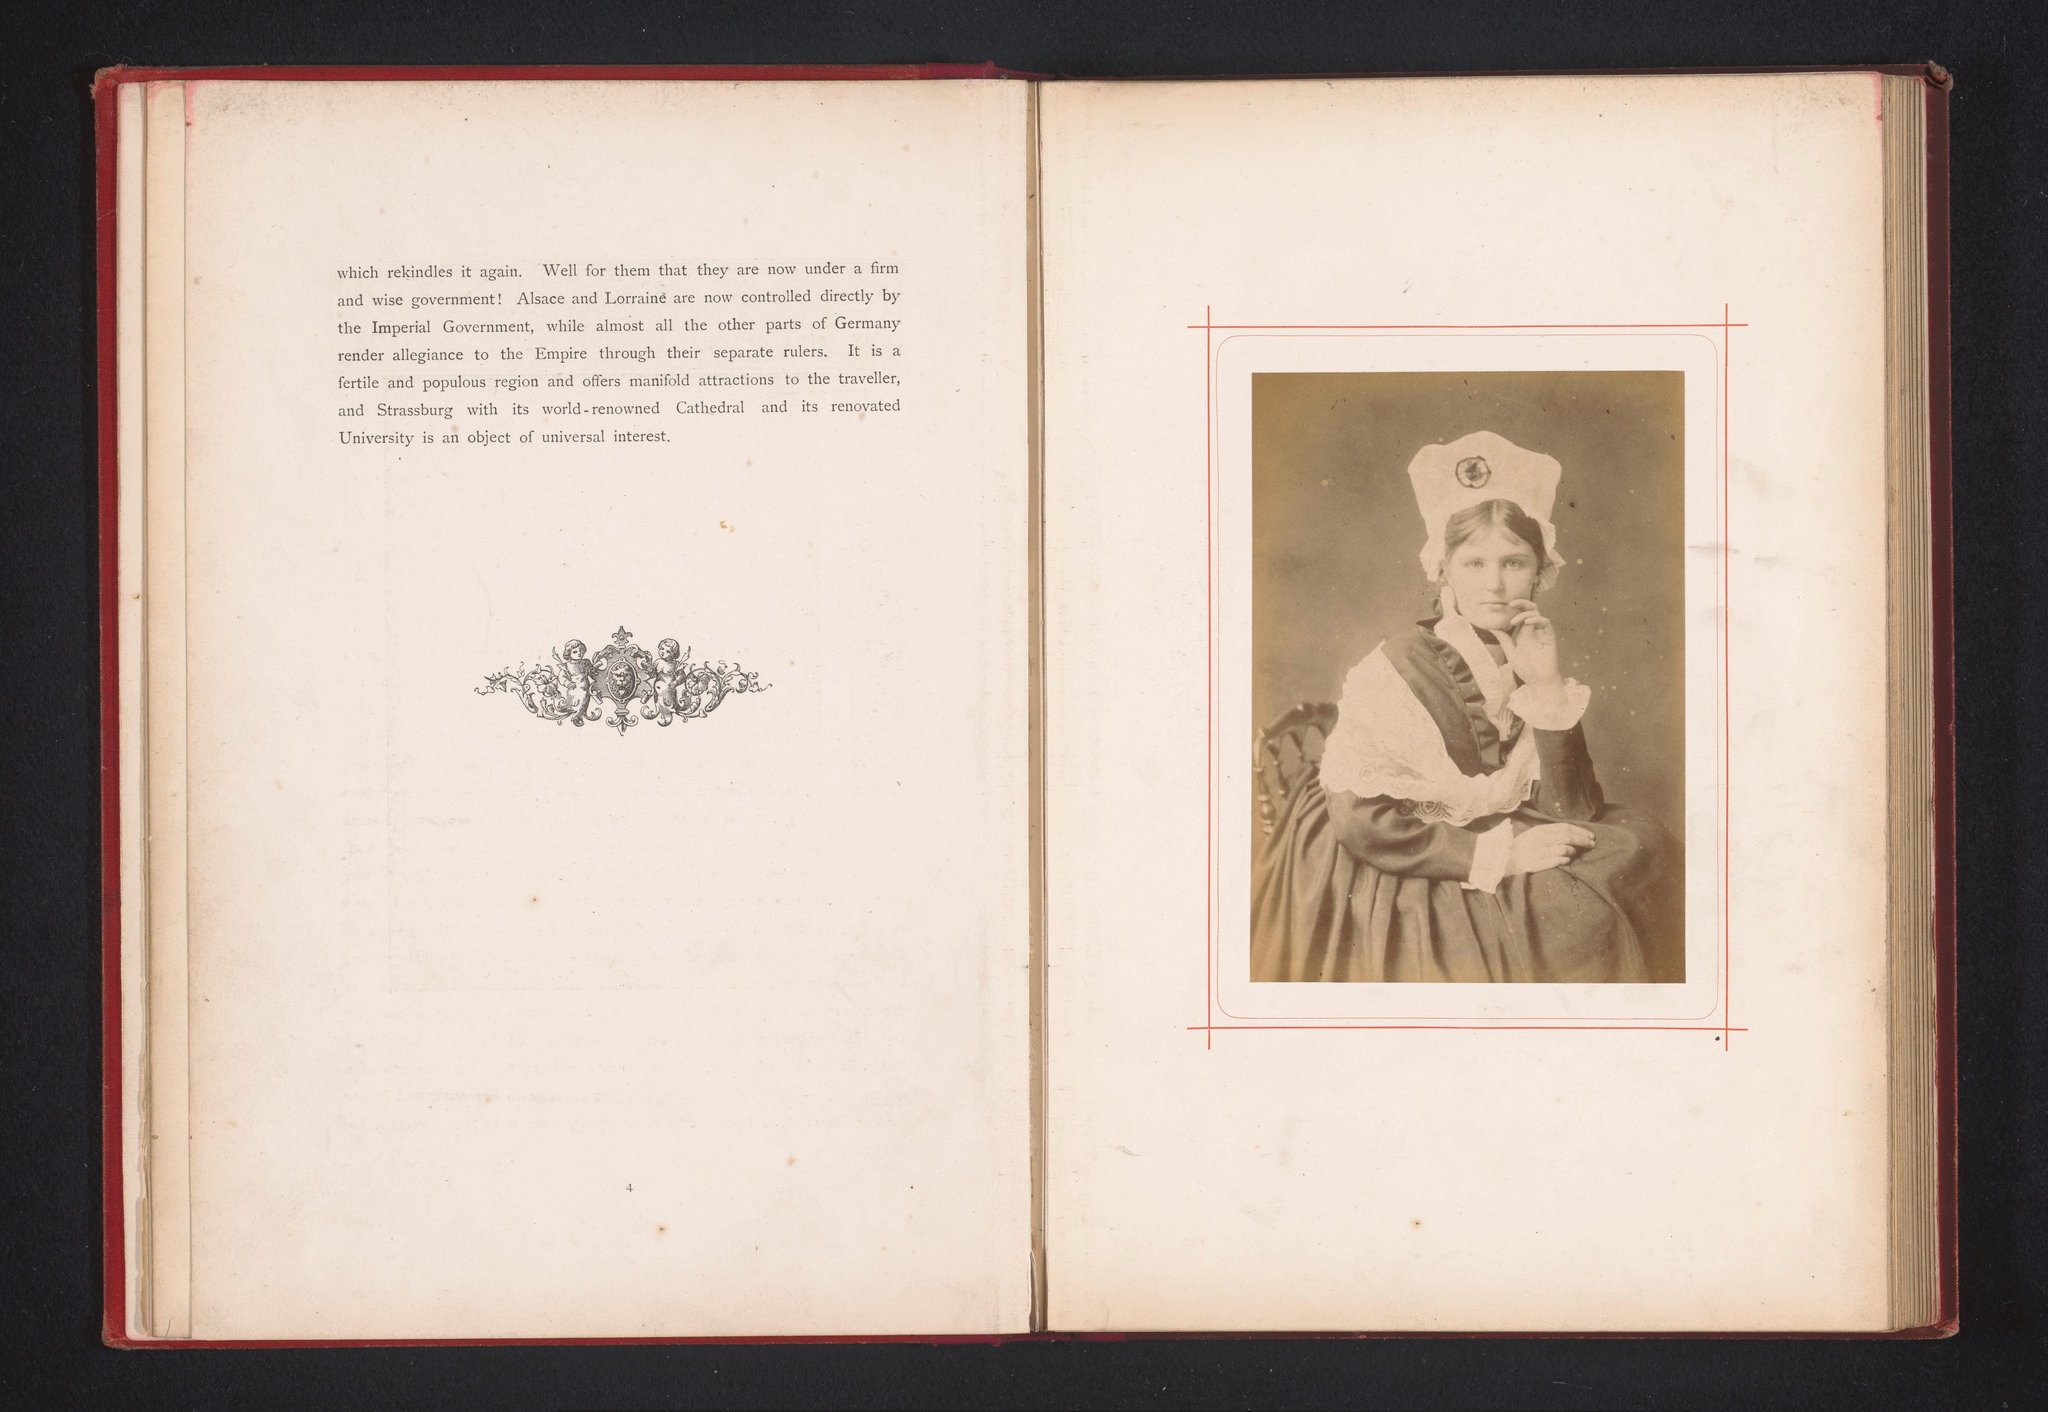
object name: photograph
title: Portret van een onbekende vrouw in klederdracht uit Lotharingen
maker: Anonymous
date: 1876-1886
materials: photographic support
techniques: albumen print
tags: folk costume, regional costume, anonymous historical person portrayed - bb - woman